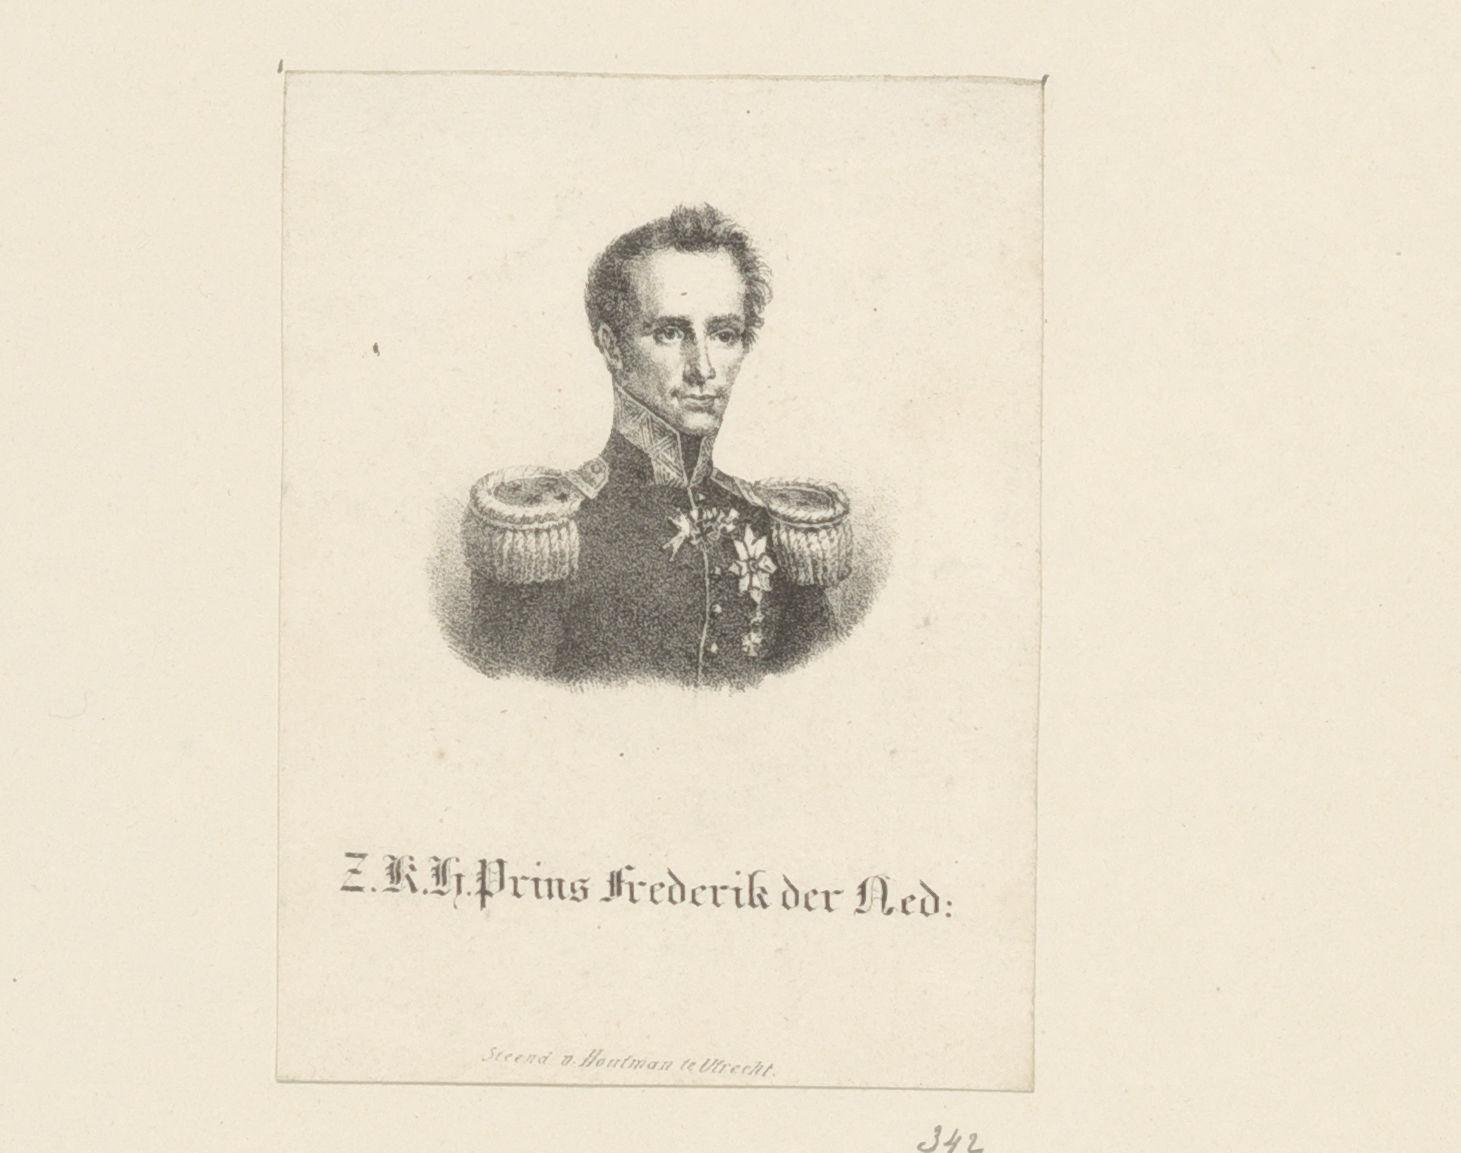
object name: print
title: Z.K.H. Prins Frederik der Ned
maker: johannes paulus houtman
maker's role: bookseller, print maker, printer, publisher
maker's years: 1803-1845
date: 1833-1834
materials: paper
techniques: lithograph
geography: utrecht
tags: berlin, frederik (prins der nederlanden), historical persons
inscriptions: stamp, collector's mark: Lugt 1641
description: Onderwerpsrubrieken binnen de Atlas Zeden en Gewoonten: Portretten, Portretten van Vorsten uit het huis van Oranje, Niet regeerende Vorsten.